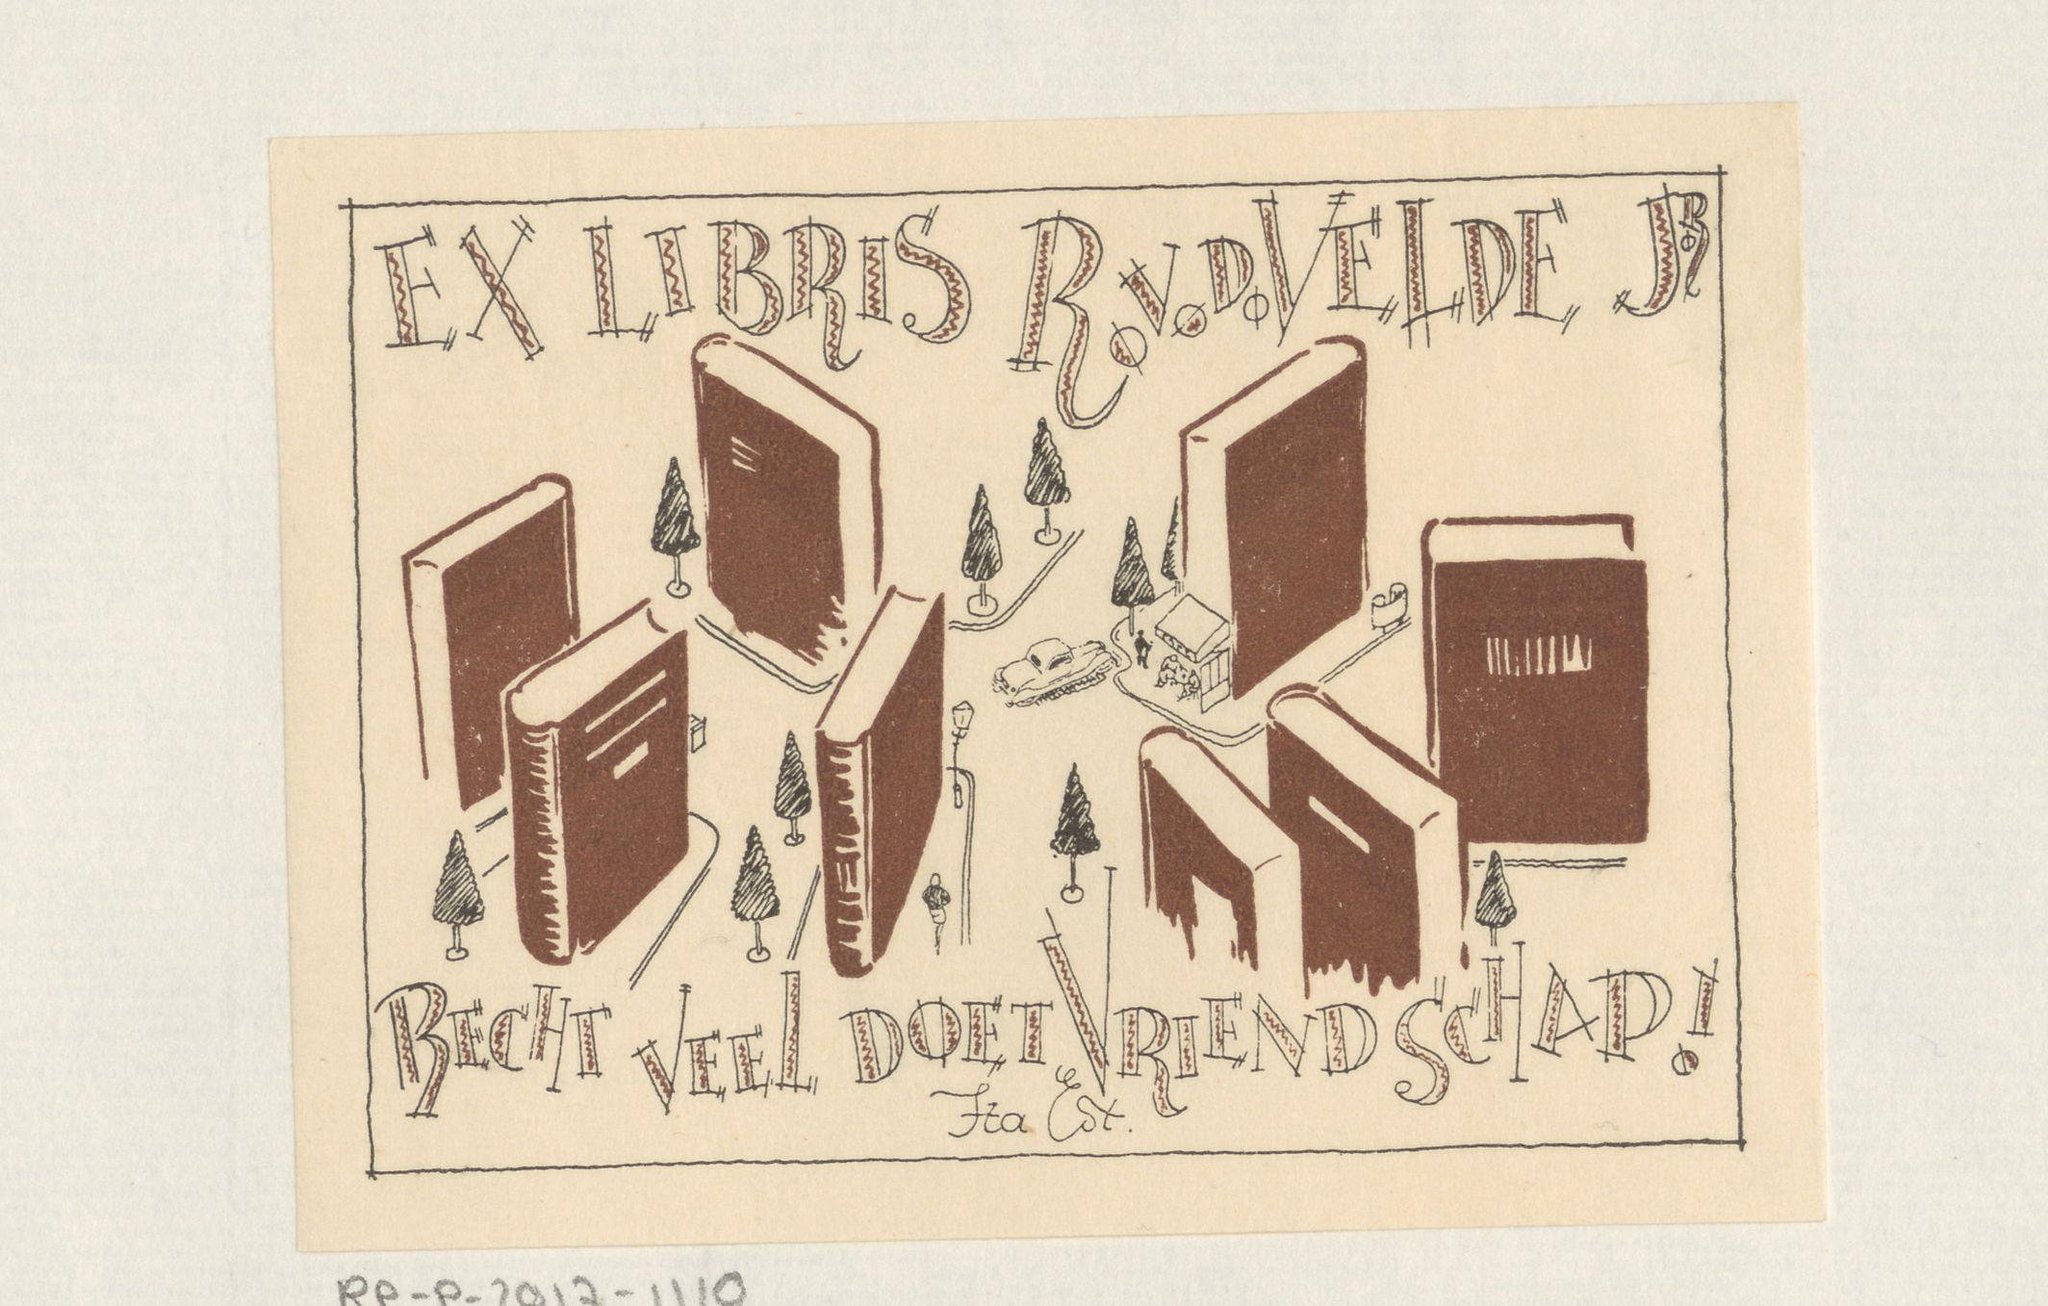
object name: bookplate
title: Ex libris van R. v.d. Velde jr.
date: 1941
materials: paper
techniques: printing block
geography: netherlands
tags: single printed leaf: broadsheet, leaflet, automobile, street